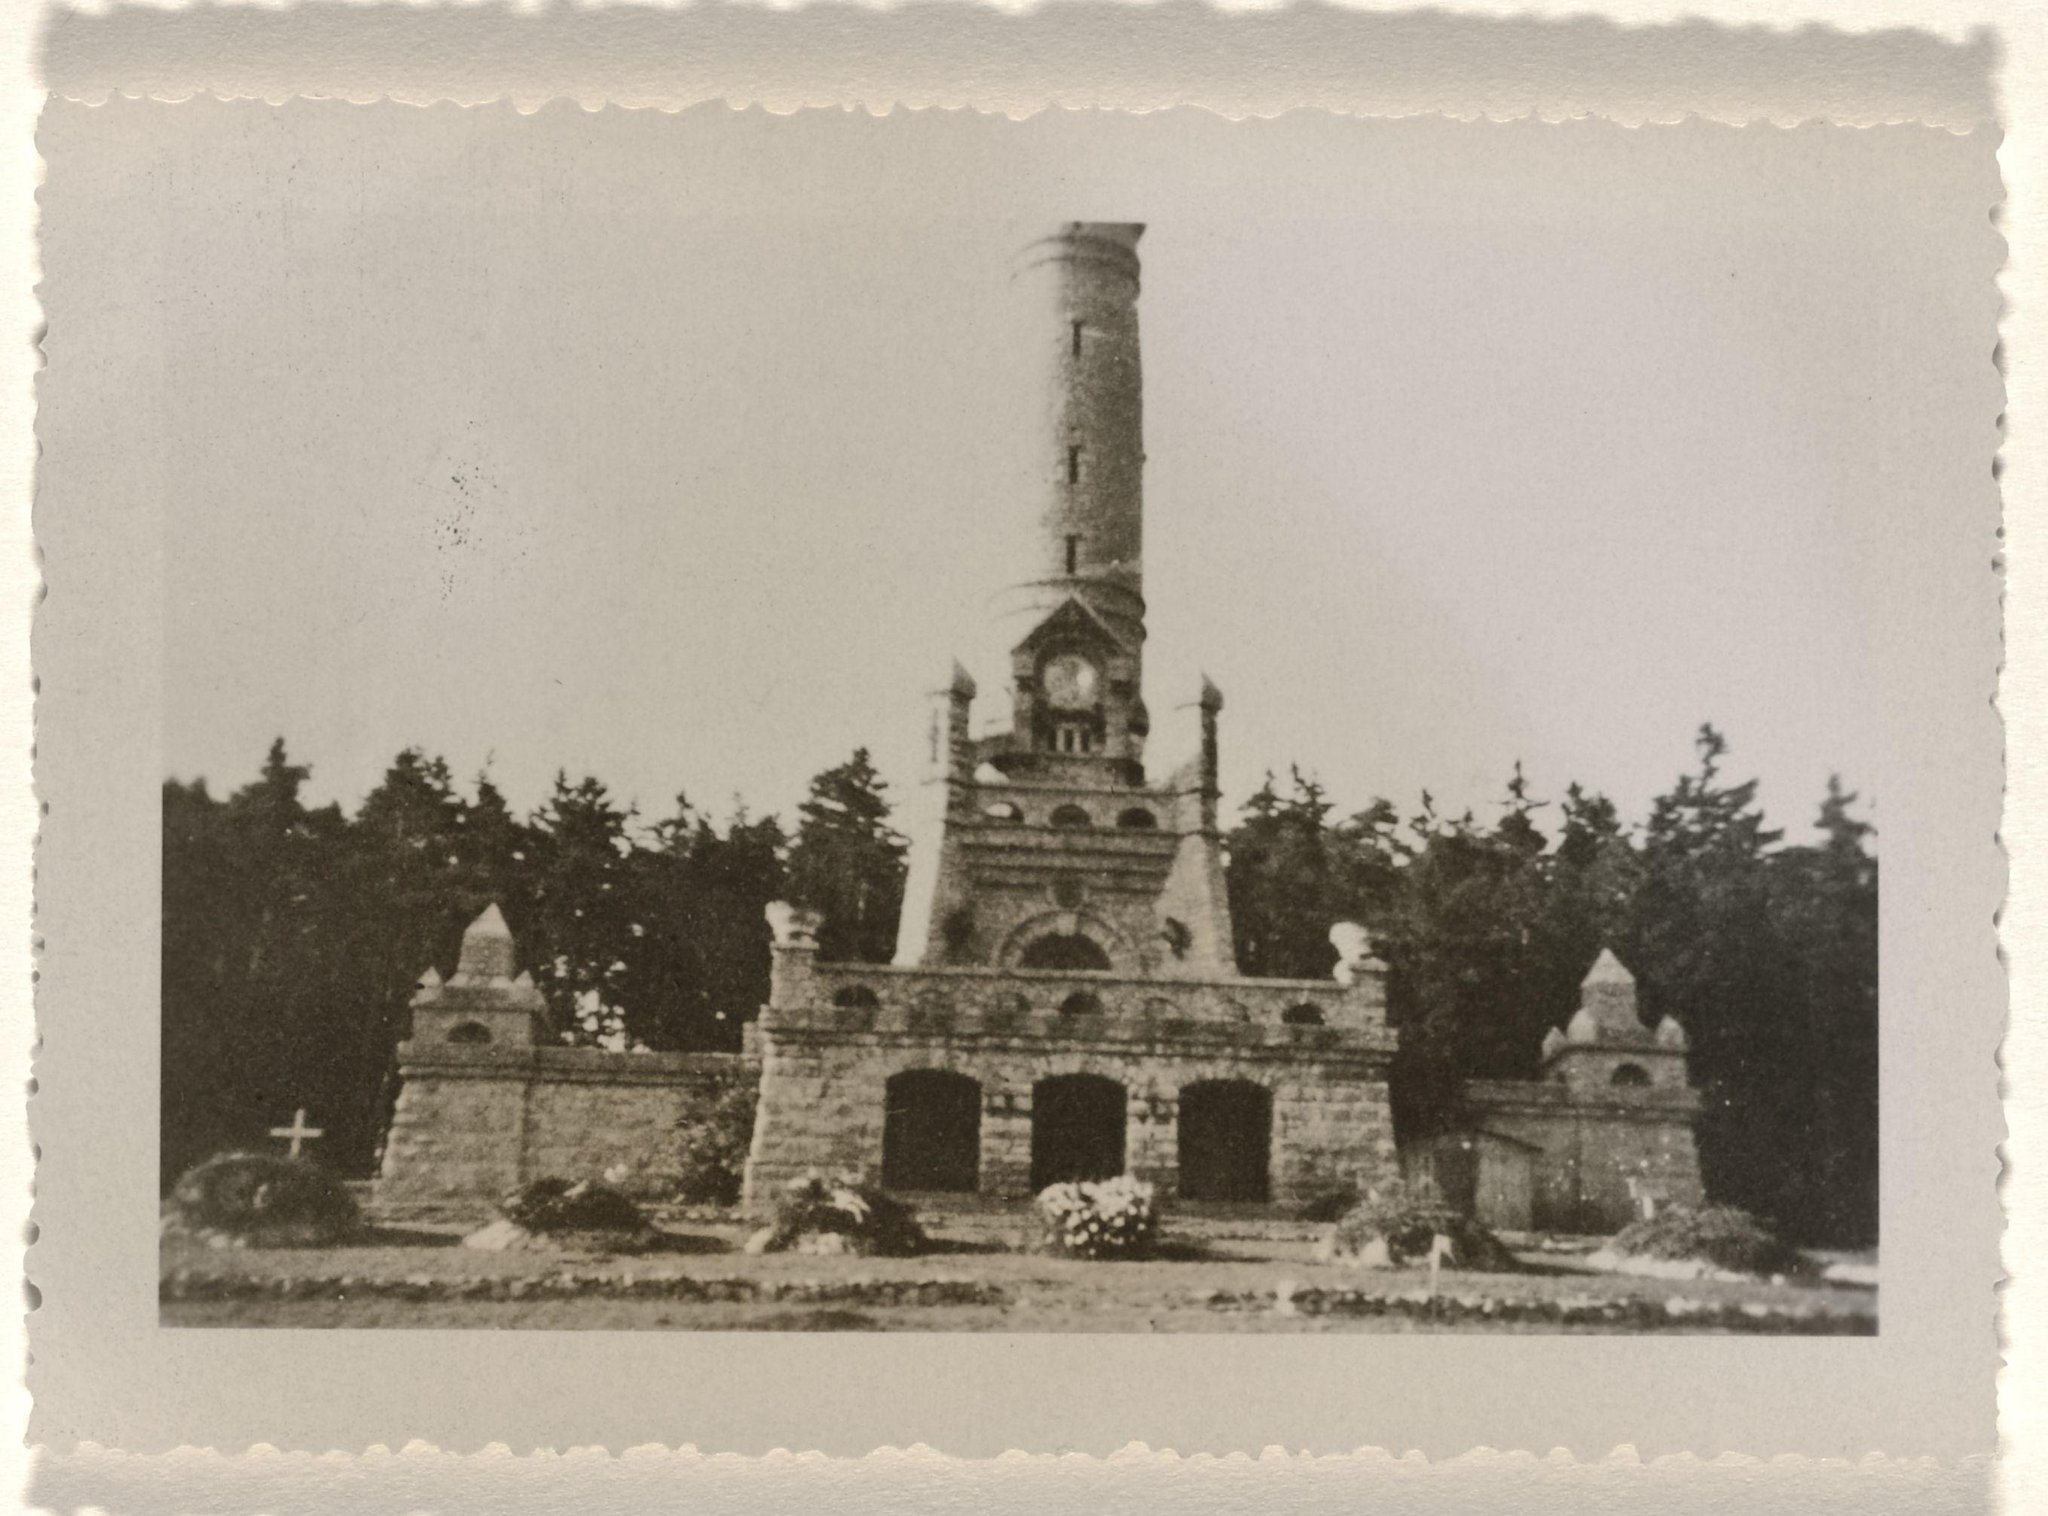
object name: photograph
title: Ruïnes van een crematorium van een concentratiekamp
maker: Anonymous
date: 1940-1945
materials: photographic support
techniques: gelatin silver print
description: Ruïnes van een crematorium van een concentratiekamp, met bomen op de achtergrond.